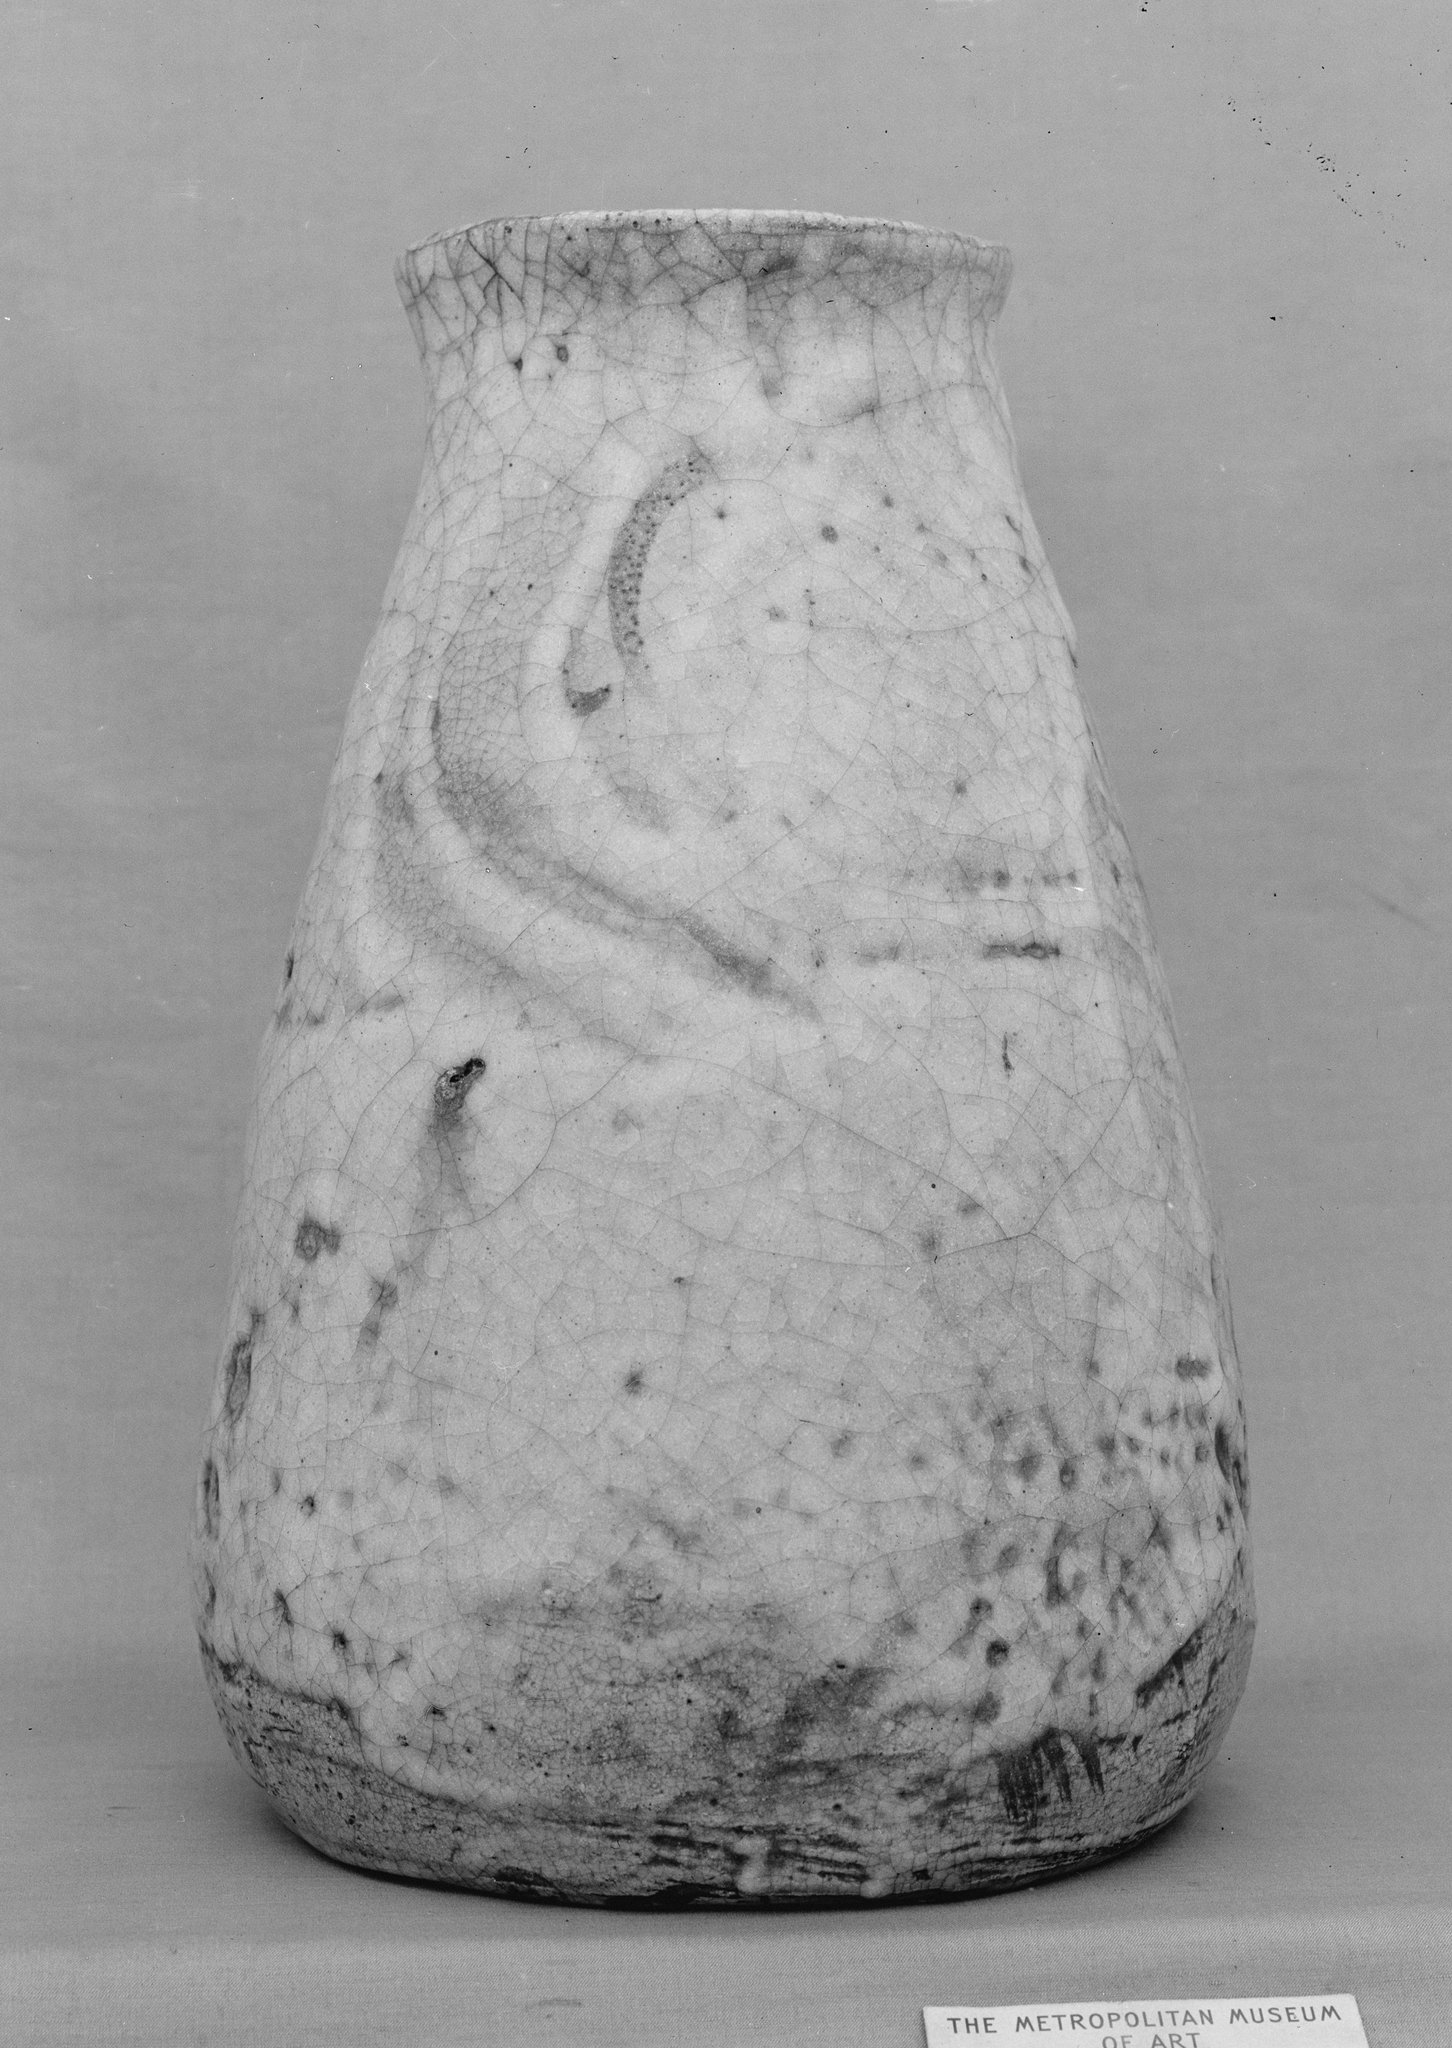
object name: flower vase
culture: japanese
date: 1701-1800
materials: glaze, paste